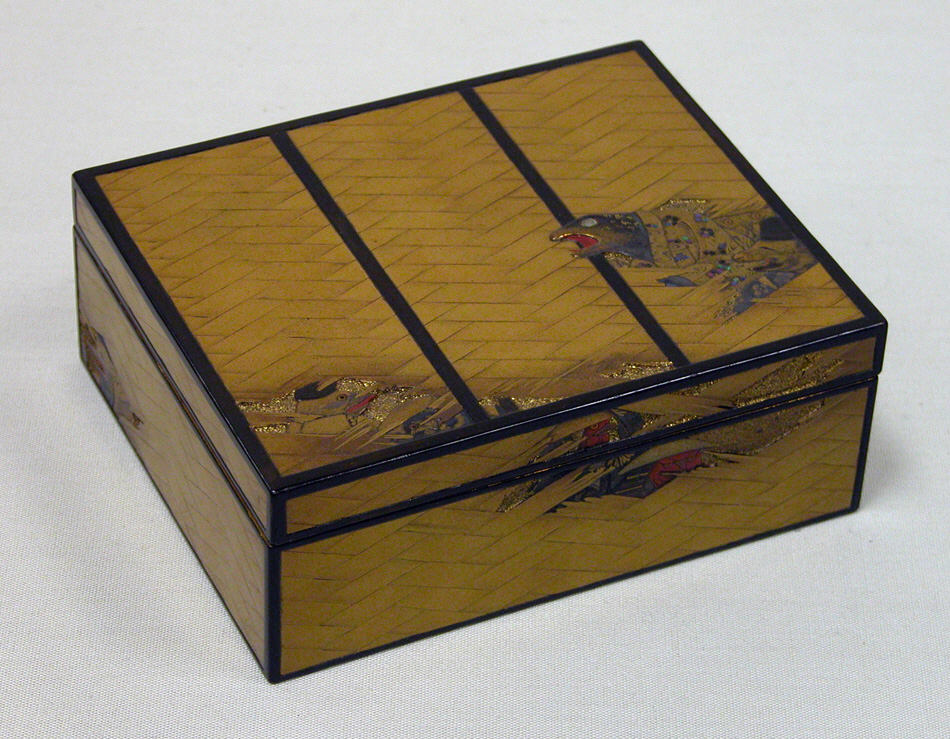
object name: box with tray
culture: japanese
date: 1701-1900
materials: lacquer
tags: mythical creatures,trays